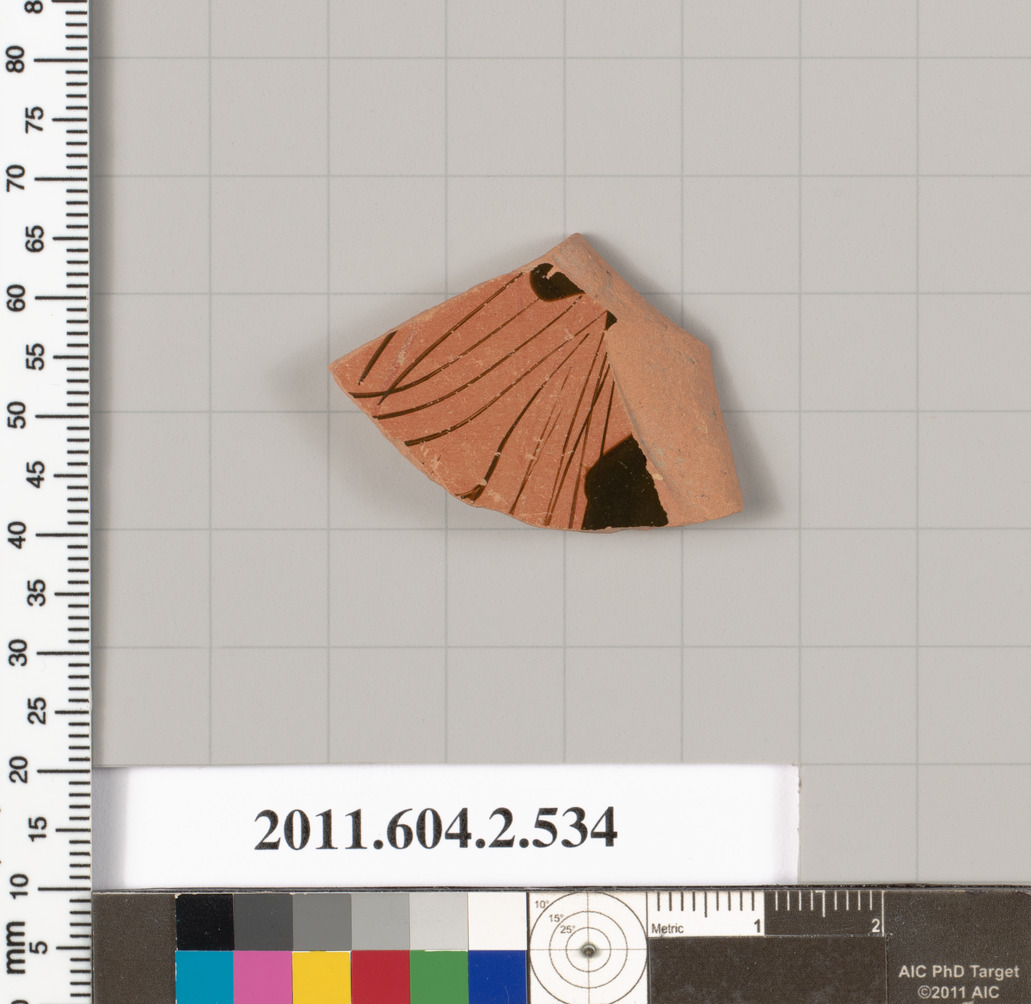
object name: column krater fragment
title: Terracotta fragment of a column-krater (bowl for mixing wine and water)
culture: greek, attic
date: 450-430 BCE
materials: terracotta